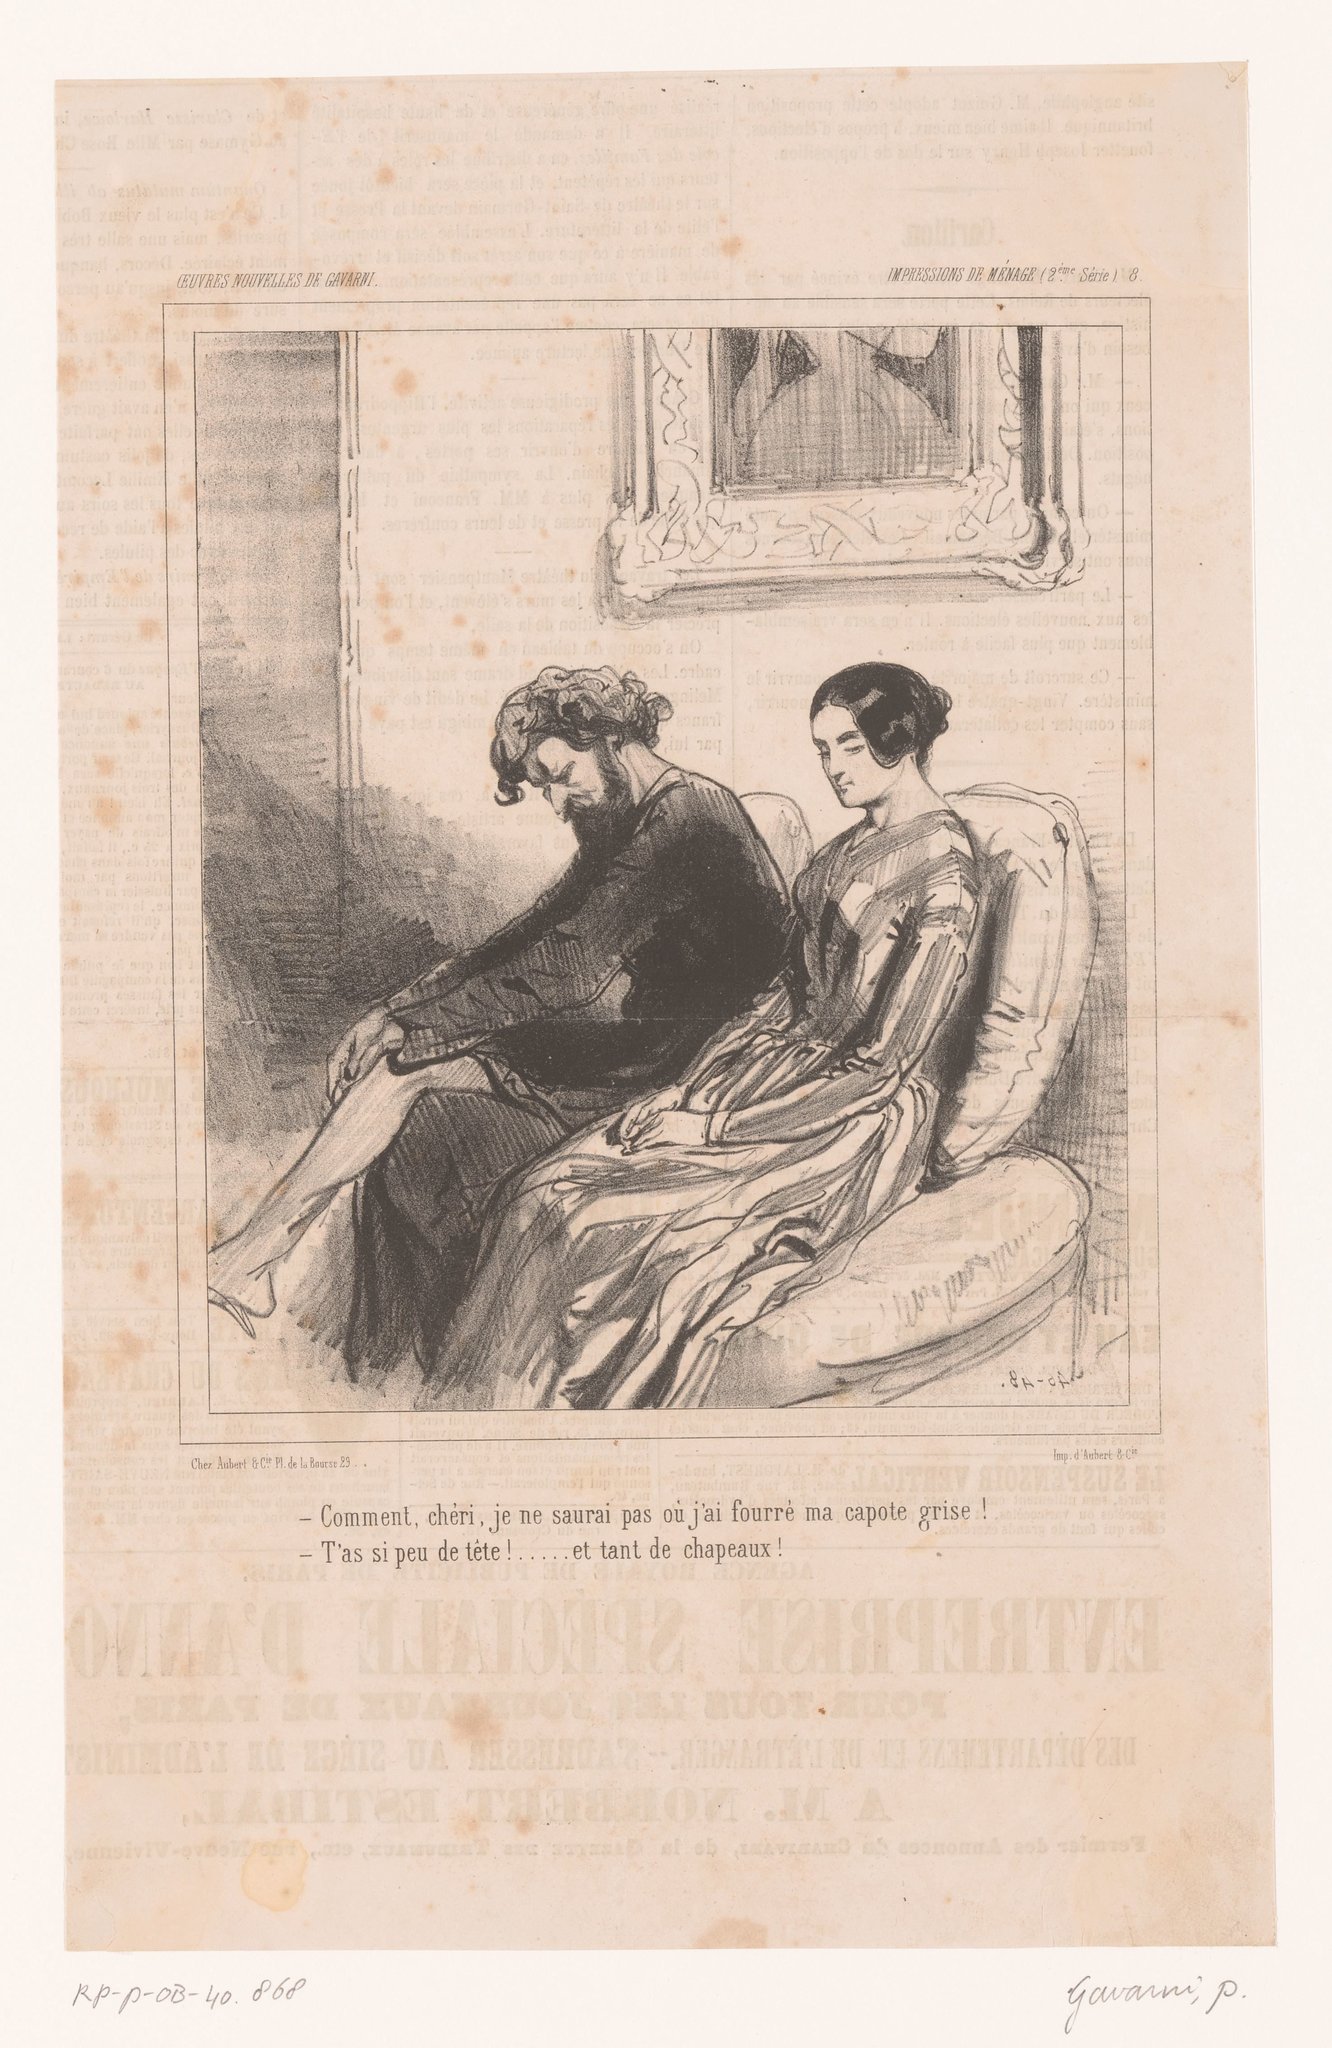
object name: cartoon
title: Echtpaar op een canapé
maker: paul gavarni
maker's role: draughtsman, print maker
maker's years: 1804-1866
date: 1846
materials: paper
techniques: lithograph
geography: paris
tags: sitting on an elevation, couch, sofa, settee, sitting on an elevation - aa - female human figure, satire on marriage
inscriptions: collector's mark: Lugt 2228a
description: De vrouw vraagt zich af waar ze haar grijze capote, een hoed met linten, heeft gelaten. Haar man verzucht: zo weinig hoofd, en zoveel hoeden!